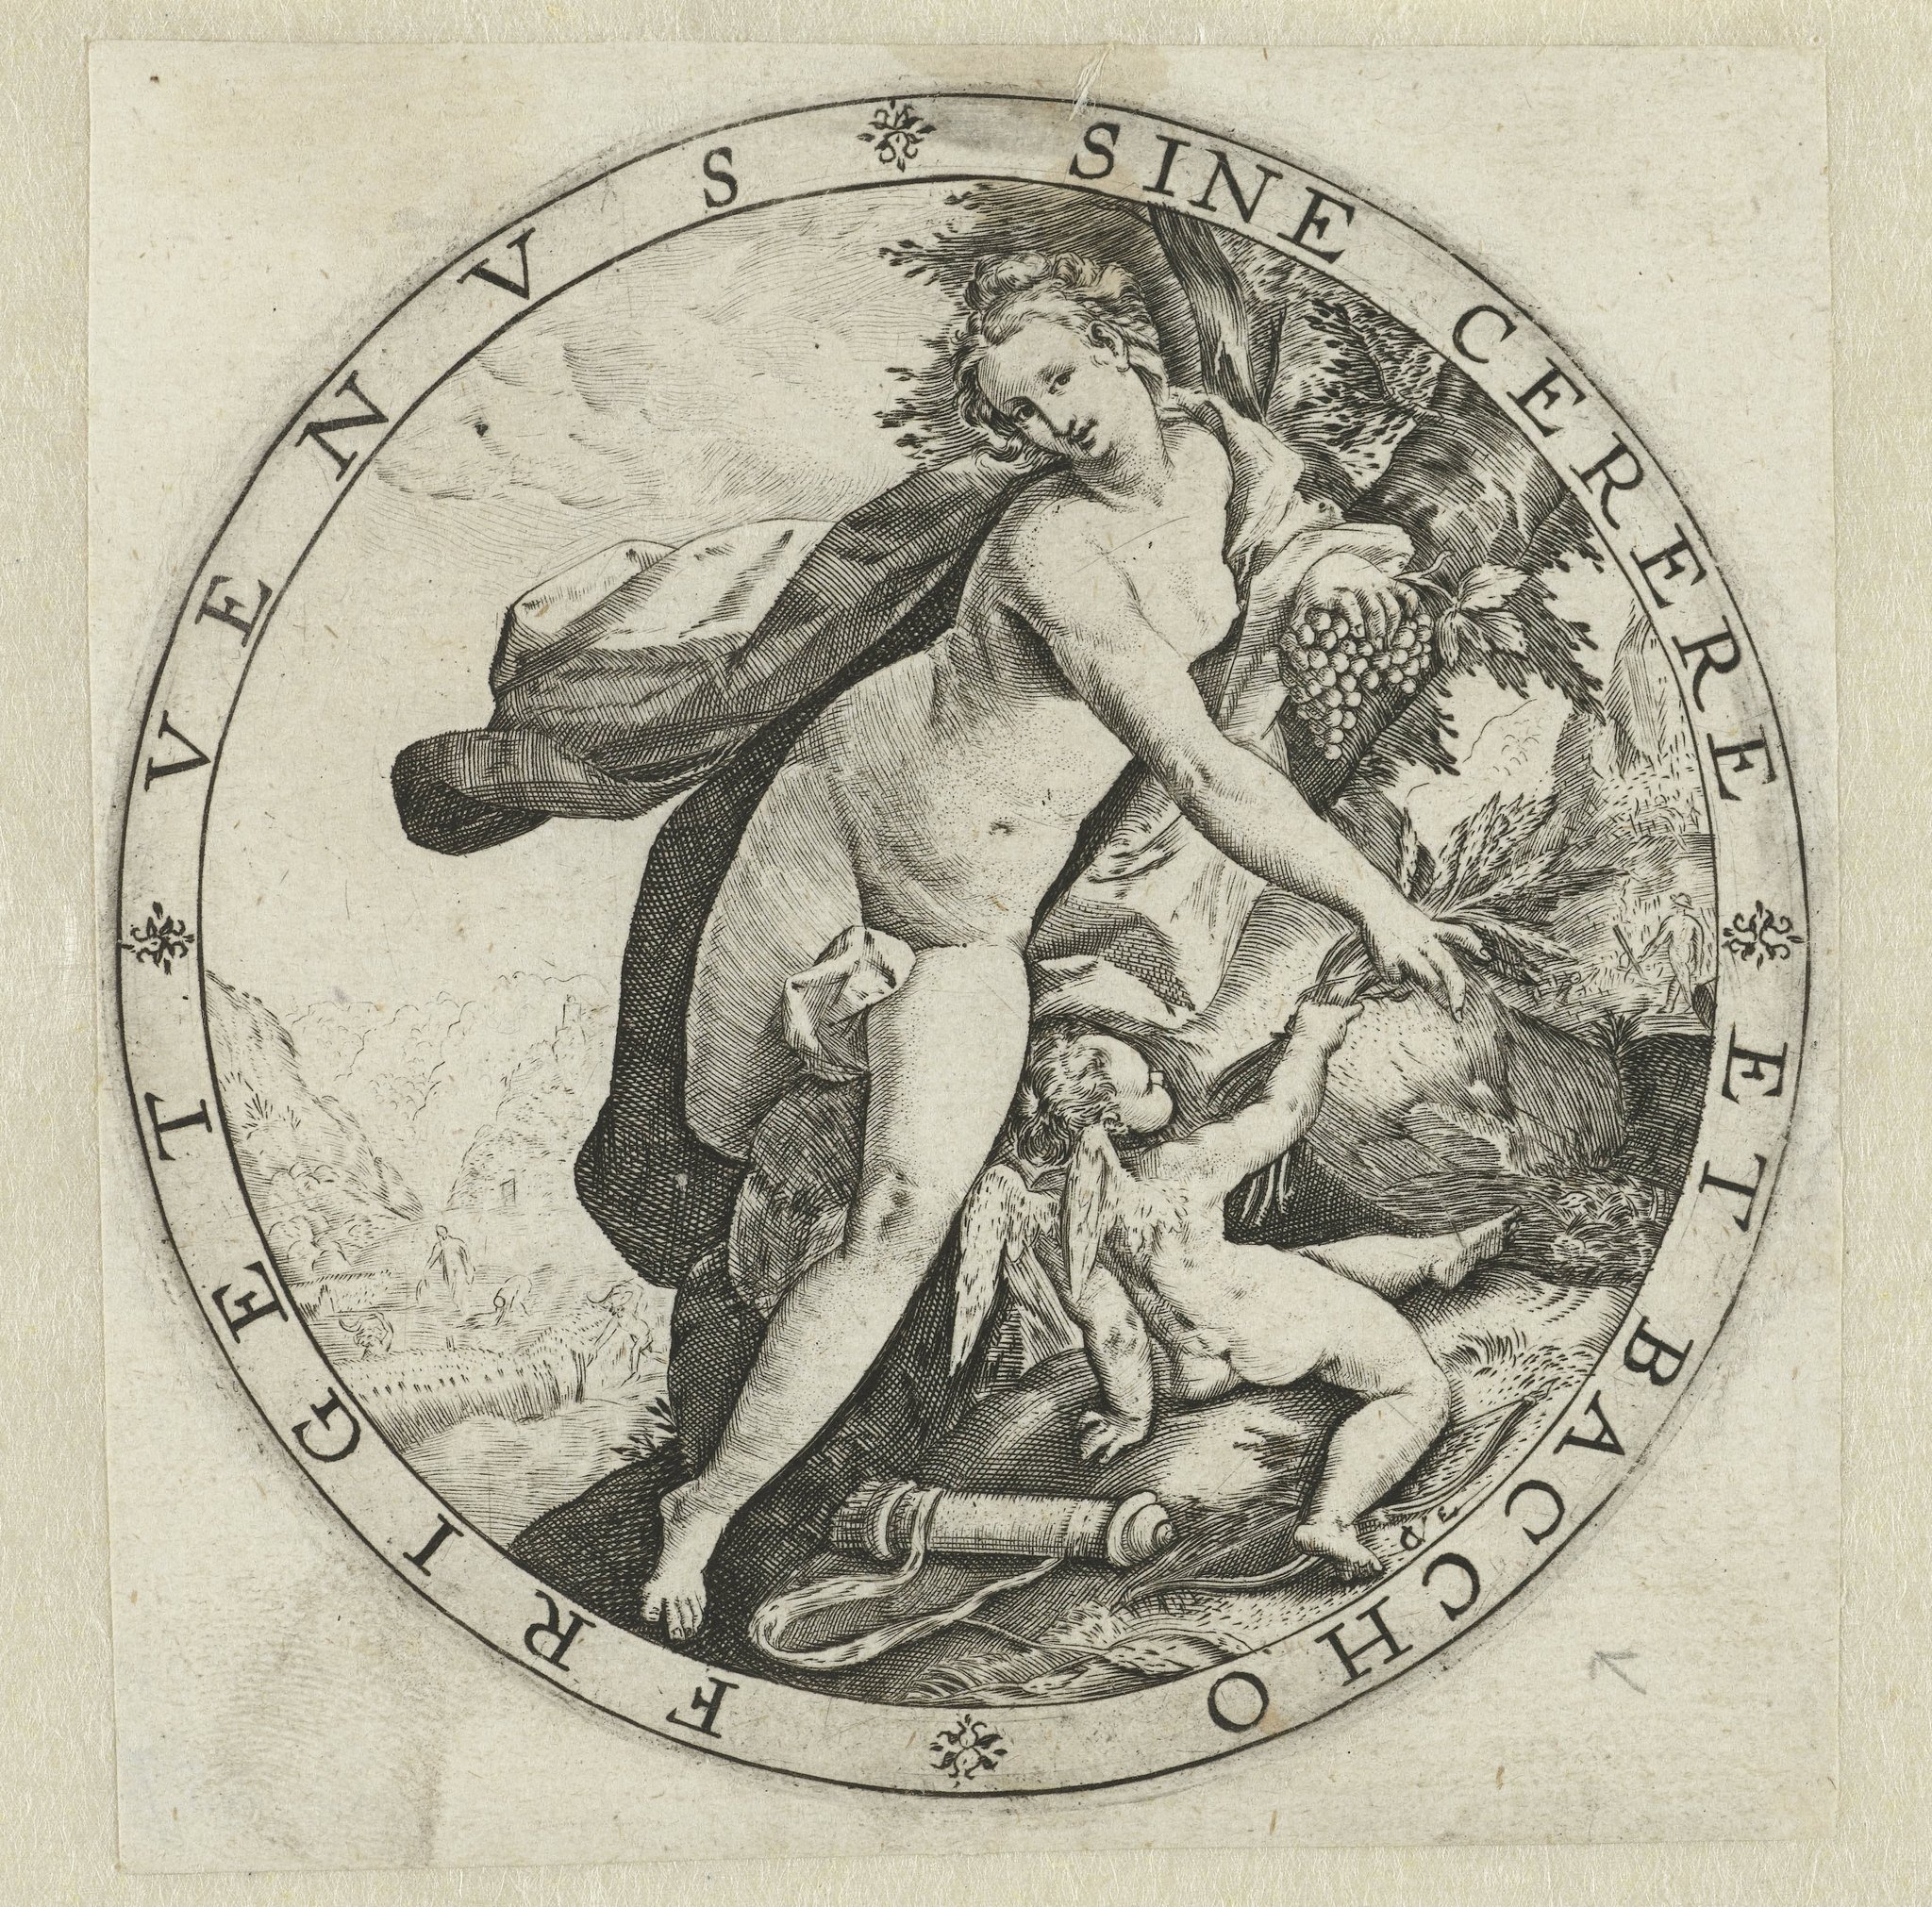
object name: print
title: Sine Cerere et Baccho friget Venus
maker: zacharias dolendo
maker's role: print maker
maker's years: 1561-1604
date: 1590-1600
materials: paper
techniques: engraving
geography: netherlands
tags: 'sine cerere et baccho friget venus'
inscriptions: collector's mark: Lugt 2228a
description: Ronde voorstelling van Venus en Cupido bij een boom. Venus heeft een tros druiven in de hand, Cupido geeft haar een bundel graan aan. Op de achtergrond graanoogsters en druivenplukkers. Rond de voorstelling de titel in randschrift in Latijn.